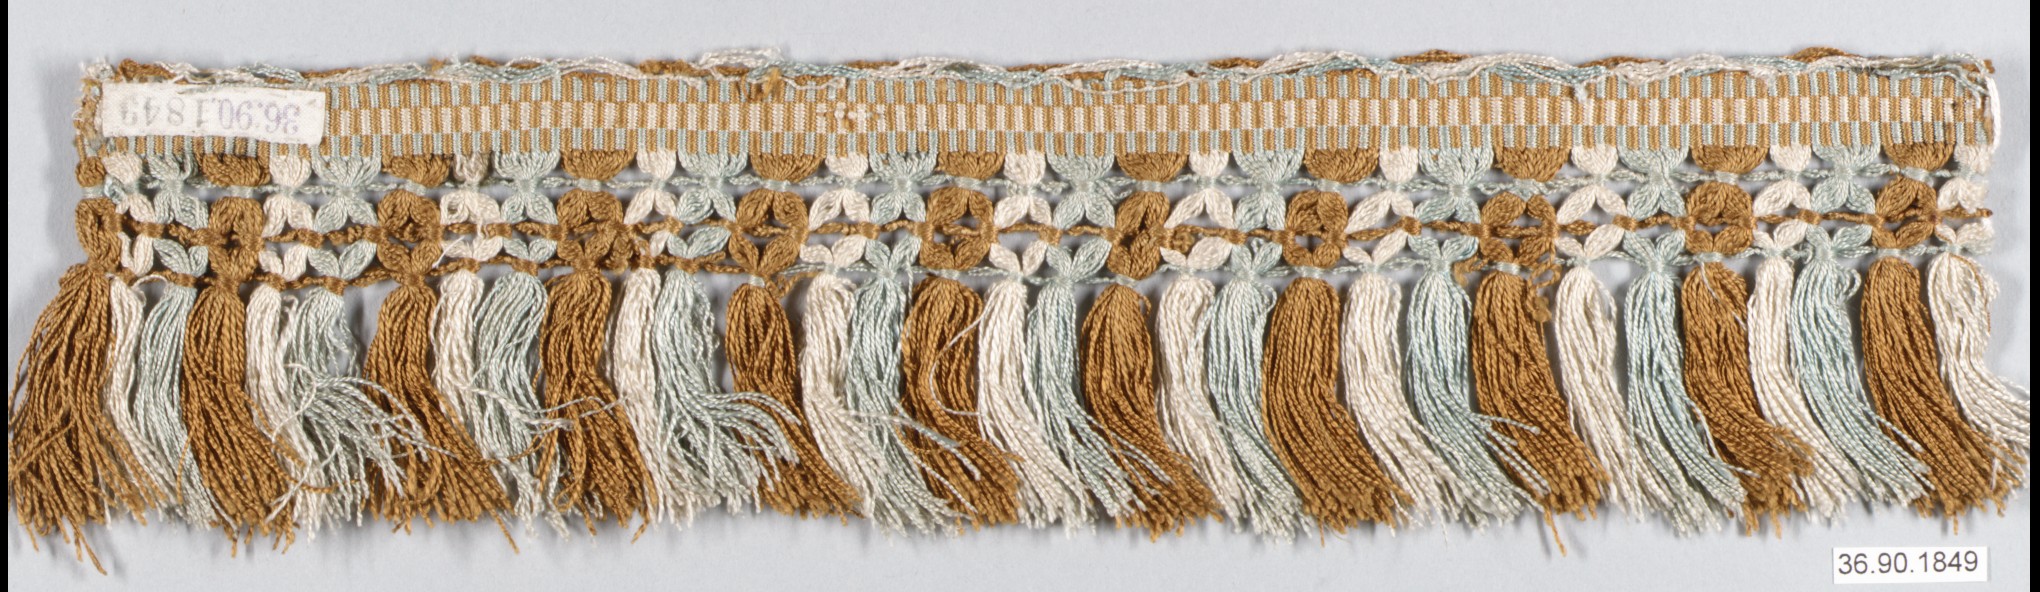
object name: fringe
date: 1734-1766